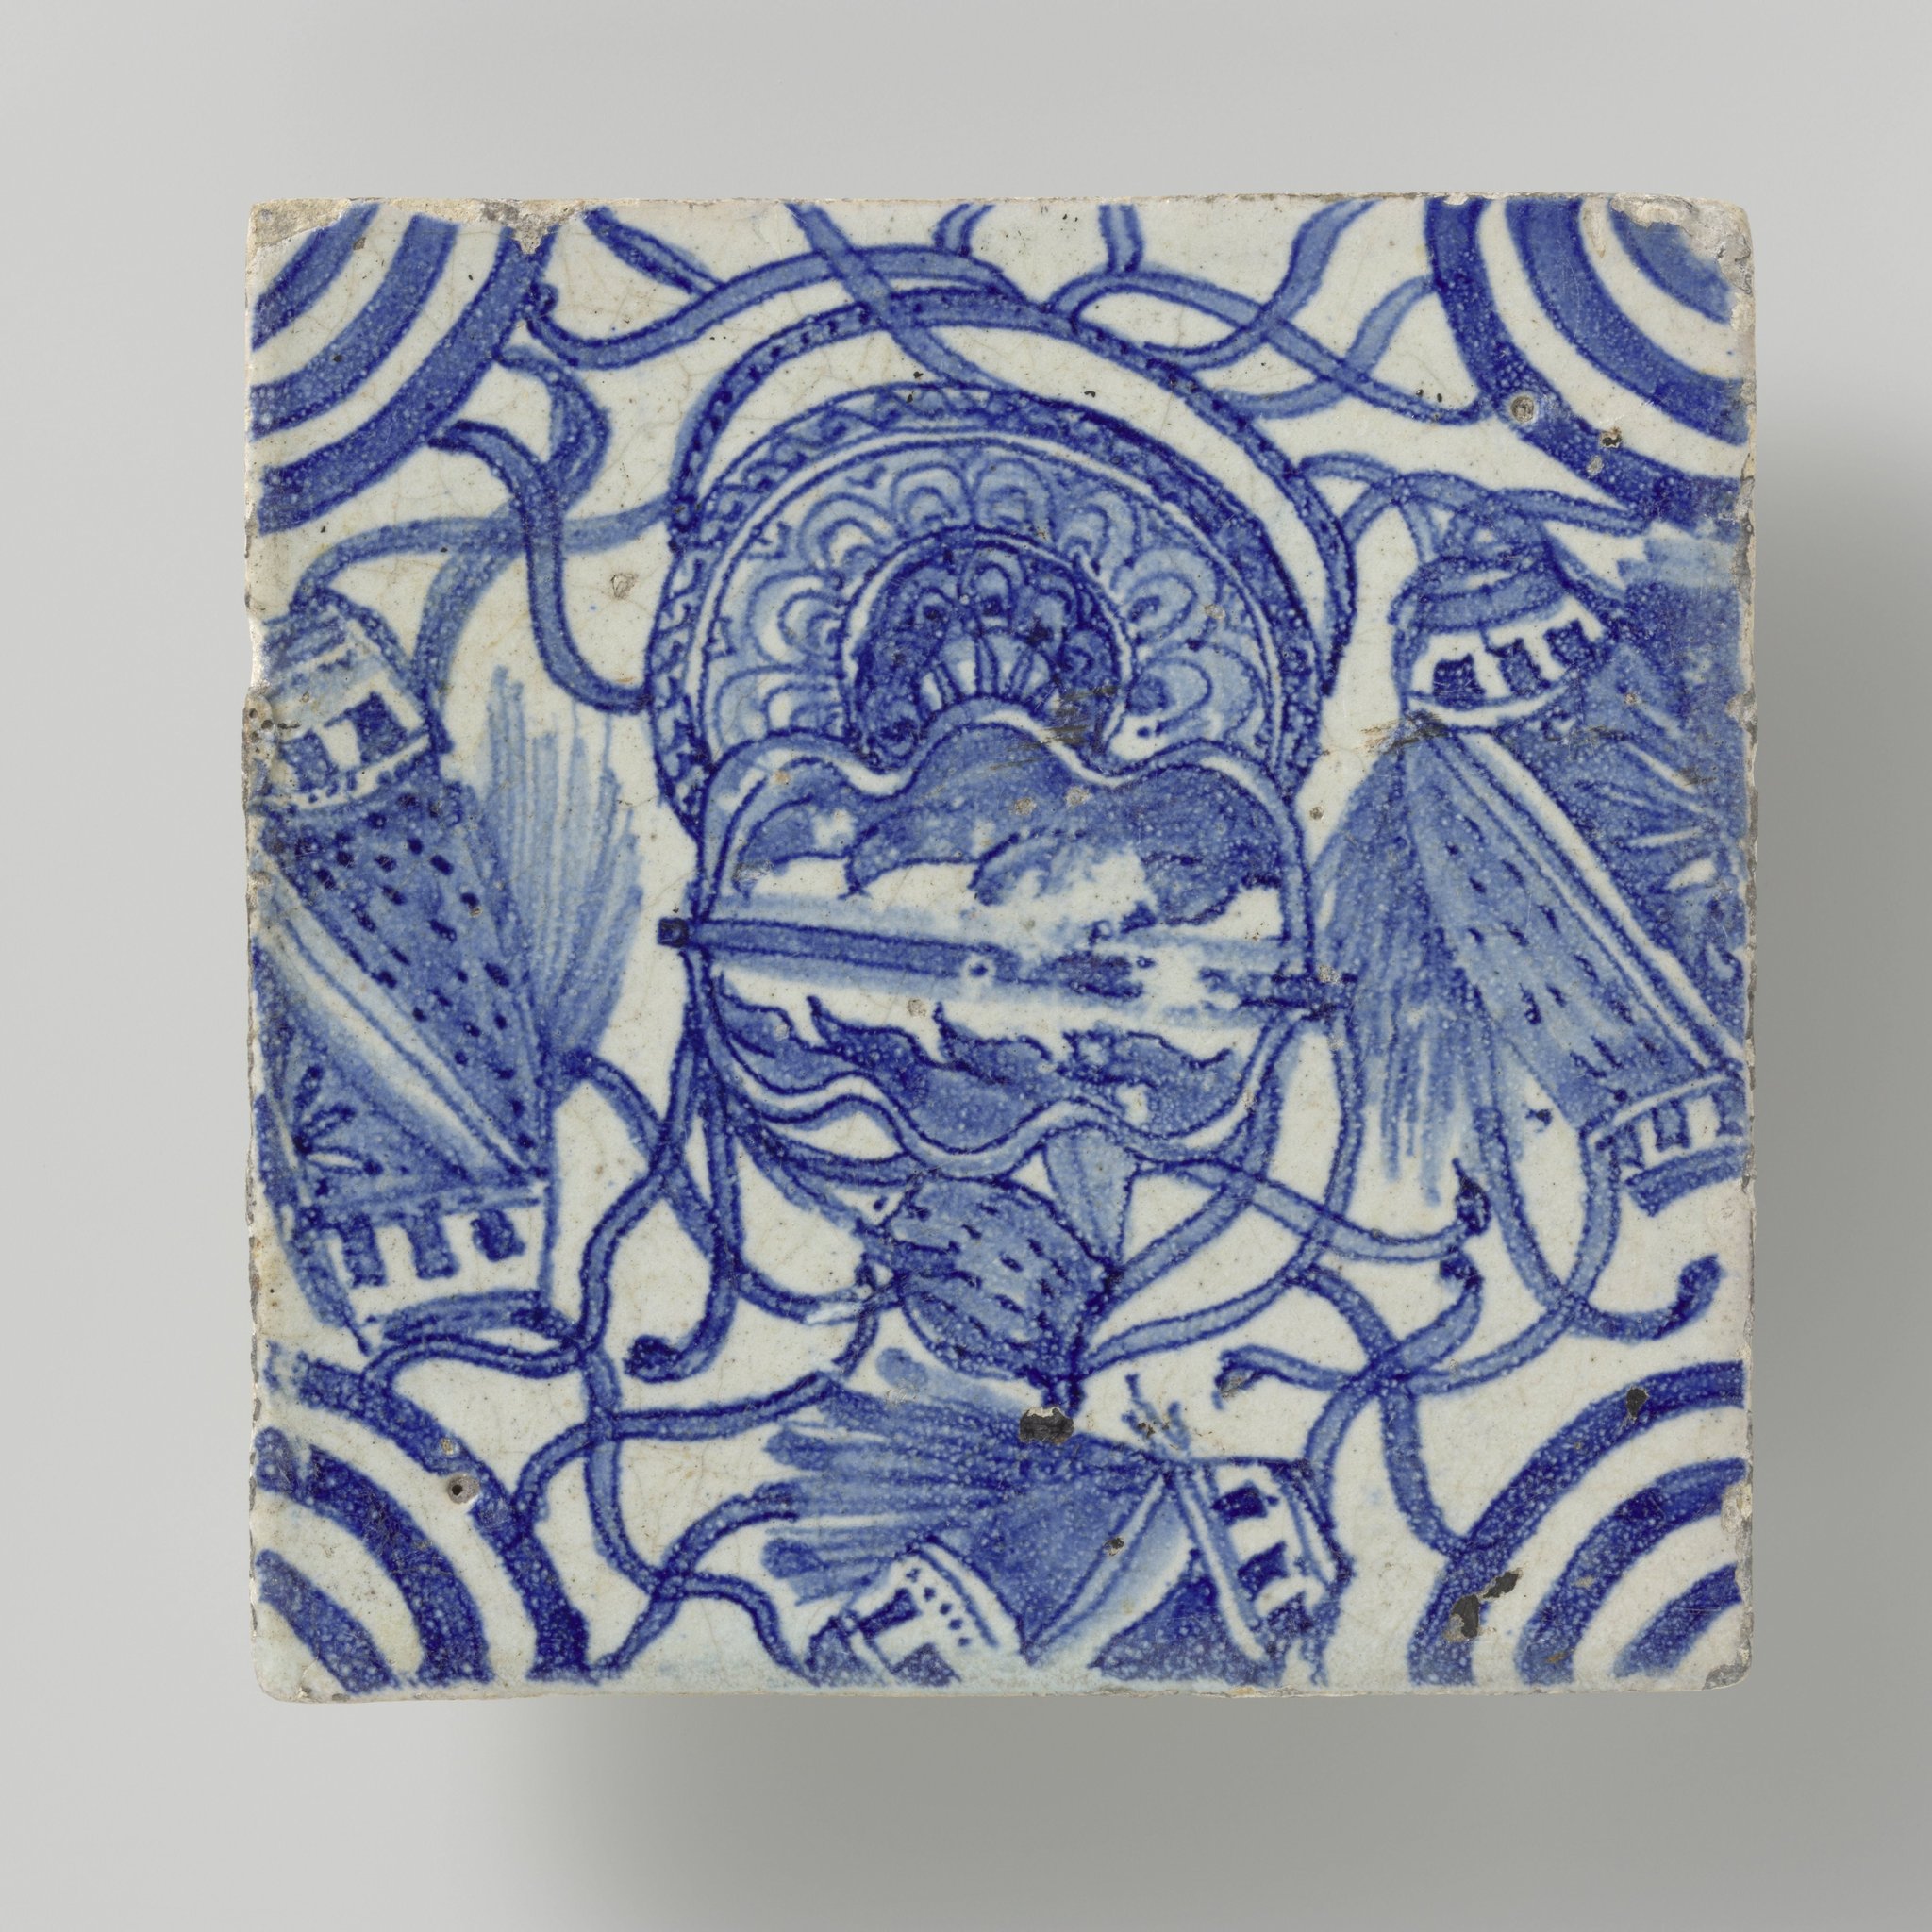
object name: tile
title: Tegel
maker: Anonymous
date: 1620-1640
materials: earthenware, glaze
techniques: maiolica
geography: netherlands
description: Tegel met Chinese motieven in blauw. In de hoeken, meander ornament.